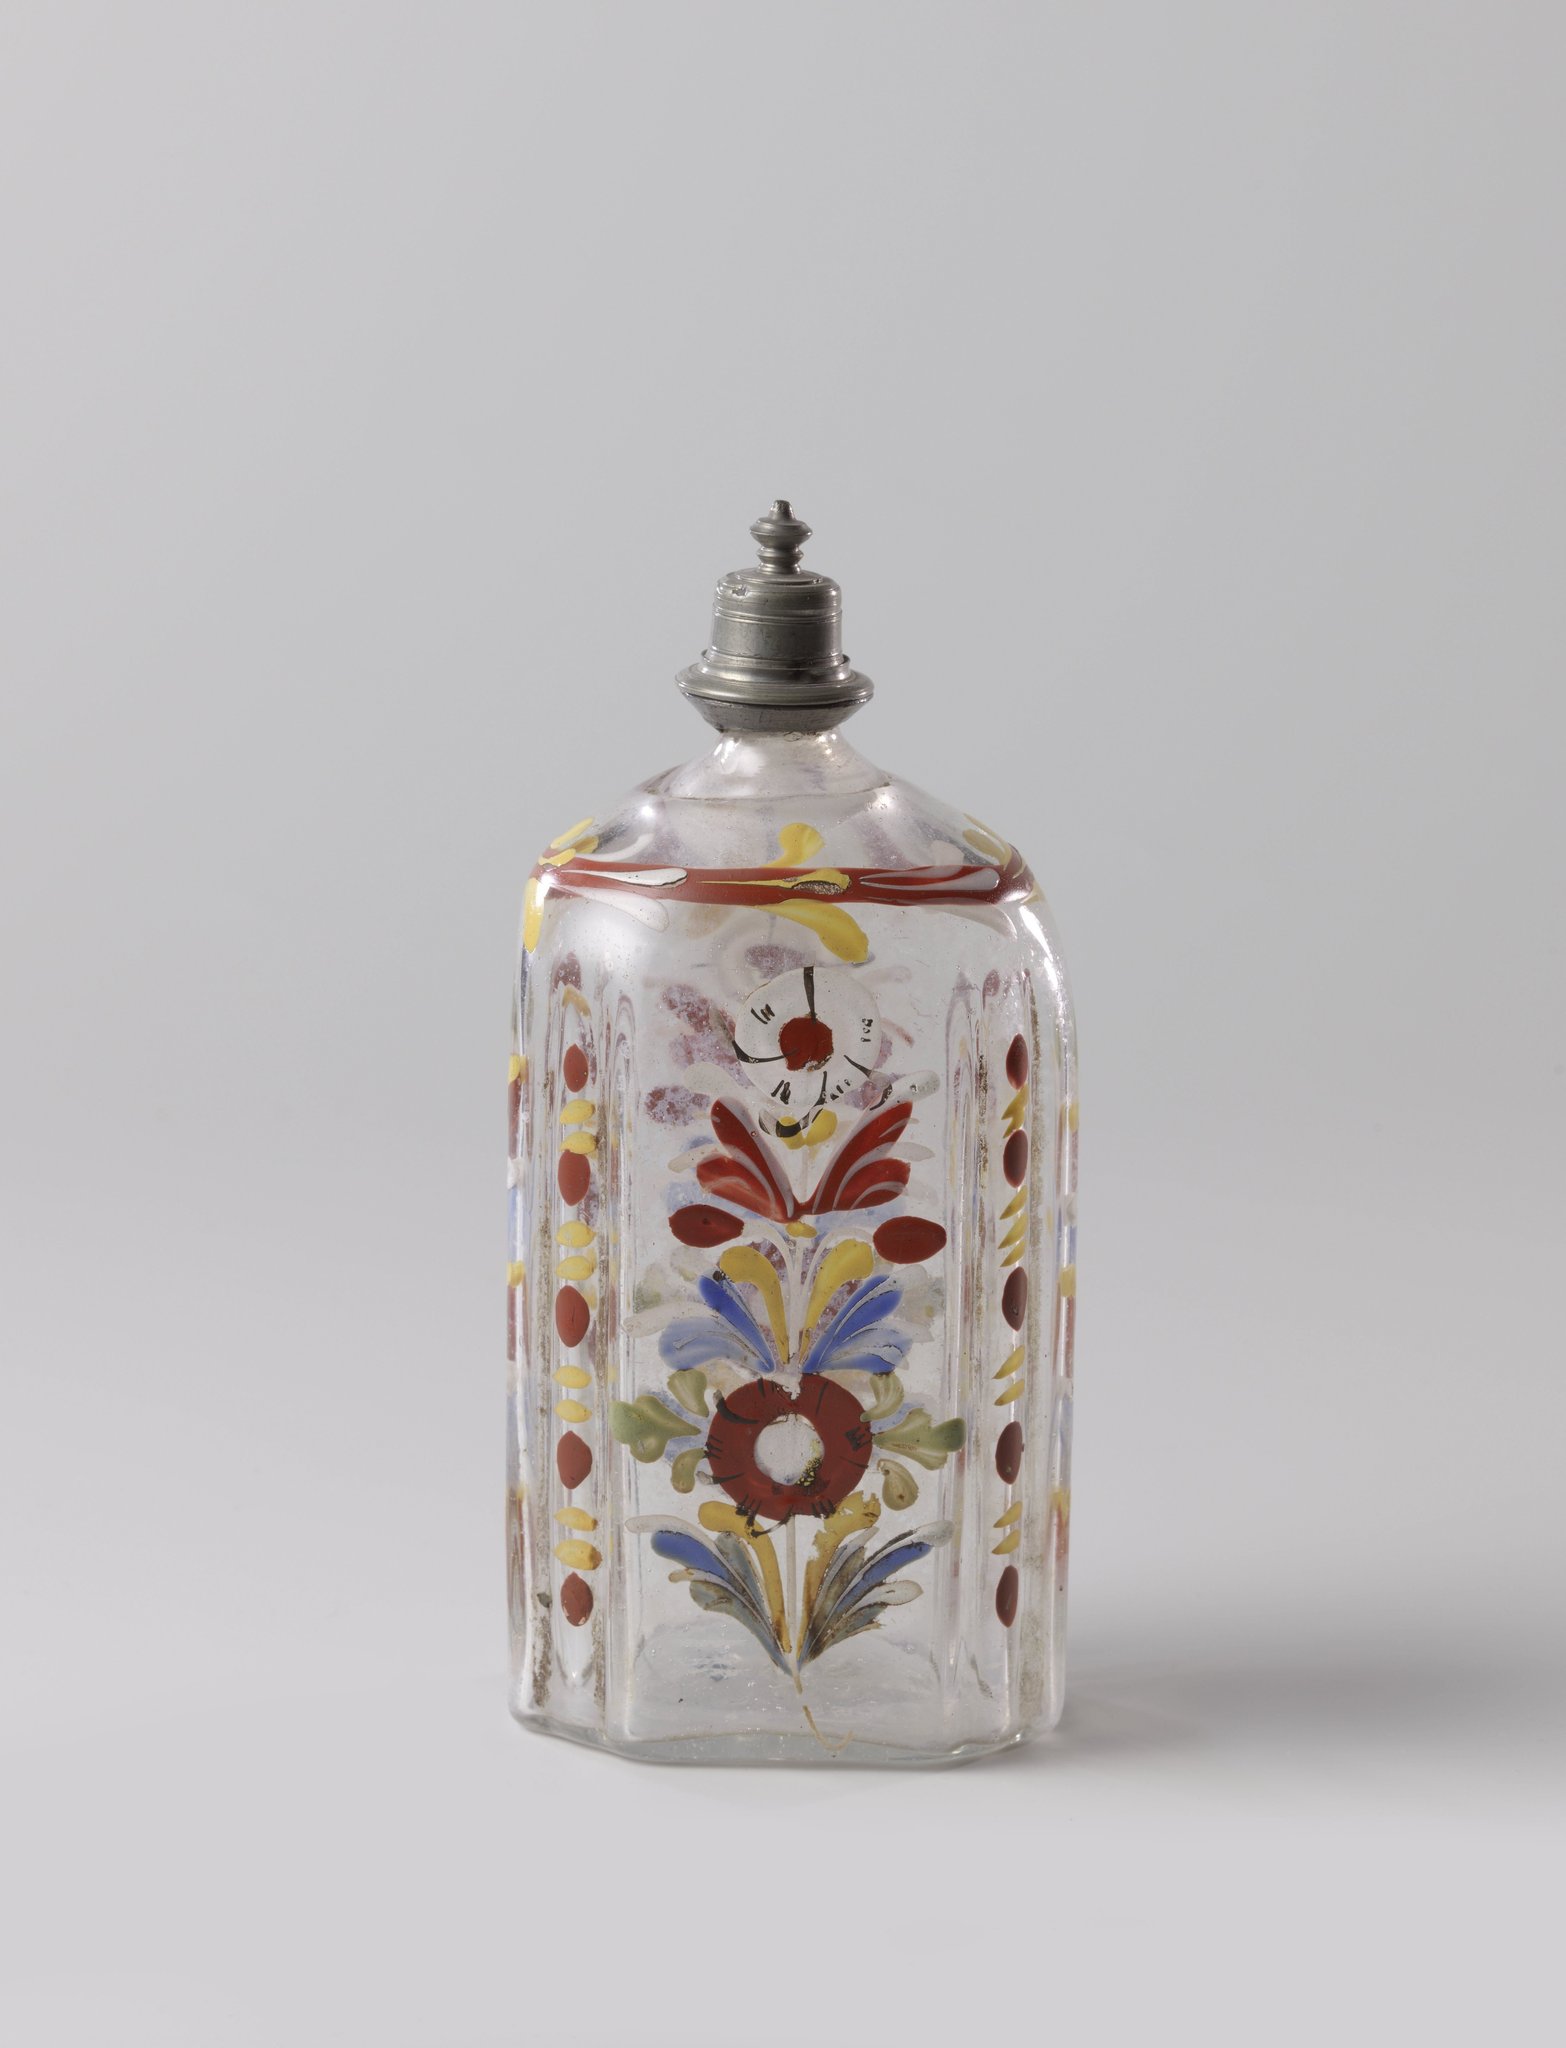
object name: bottle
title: Fles met bloemranken, heestertakken en stip- en streepornament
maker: Anonymous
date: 1700-1800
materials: glass, tin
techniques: glassblowing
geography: central europe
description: Vlakke bodem, Rechthoekig, in de vorm geblazen lichaam met geprofileerde hoeken met in geel, blauw, wit, groen en rood gestileerde bloemranken op de voor- en achterzijde en heestertakjes en stip- en streepornament op de smalle kanten en de hoeken. De hals is gevat in een tinnen montuur. Met gewelfde schroefdop.